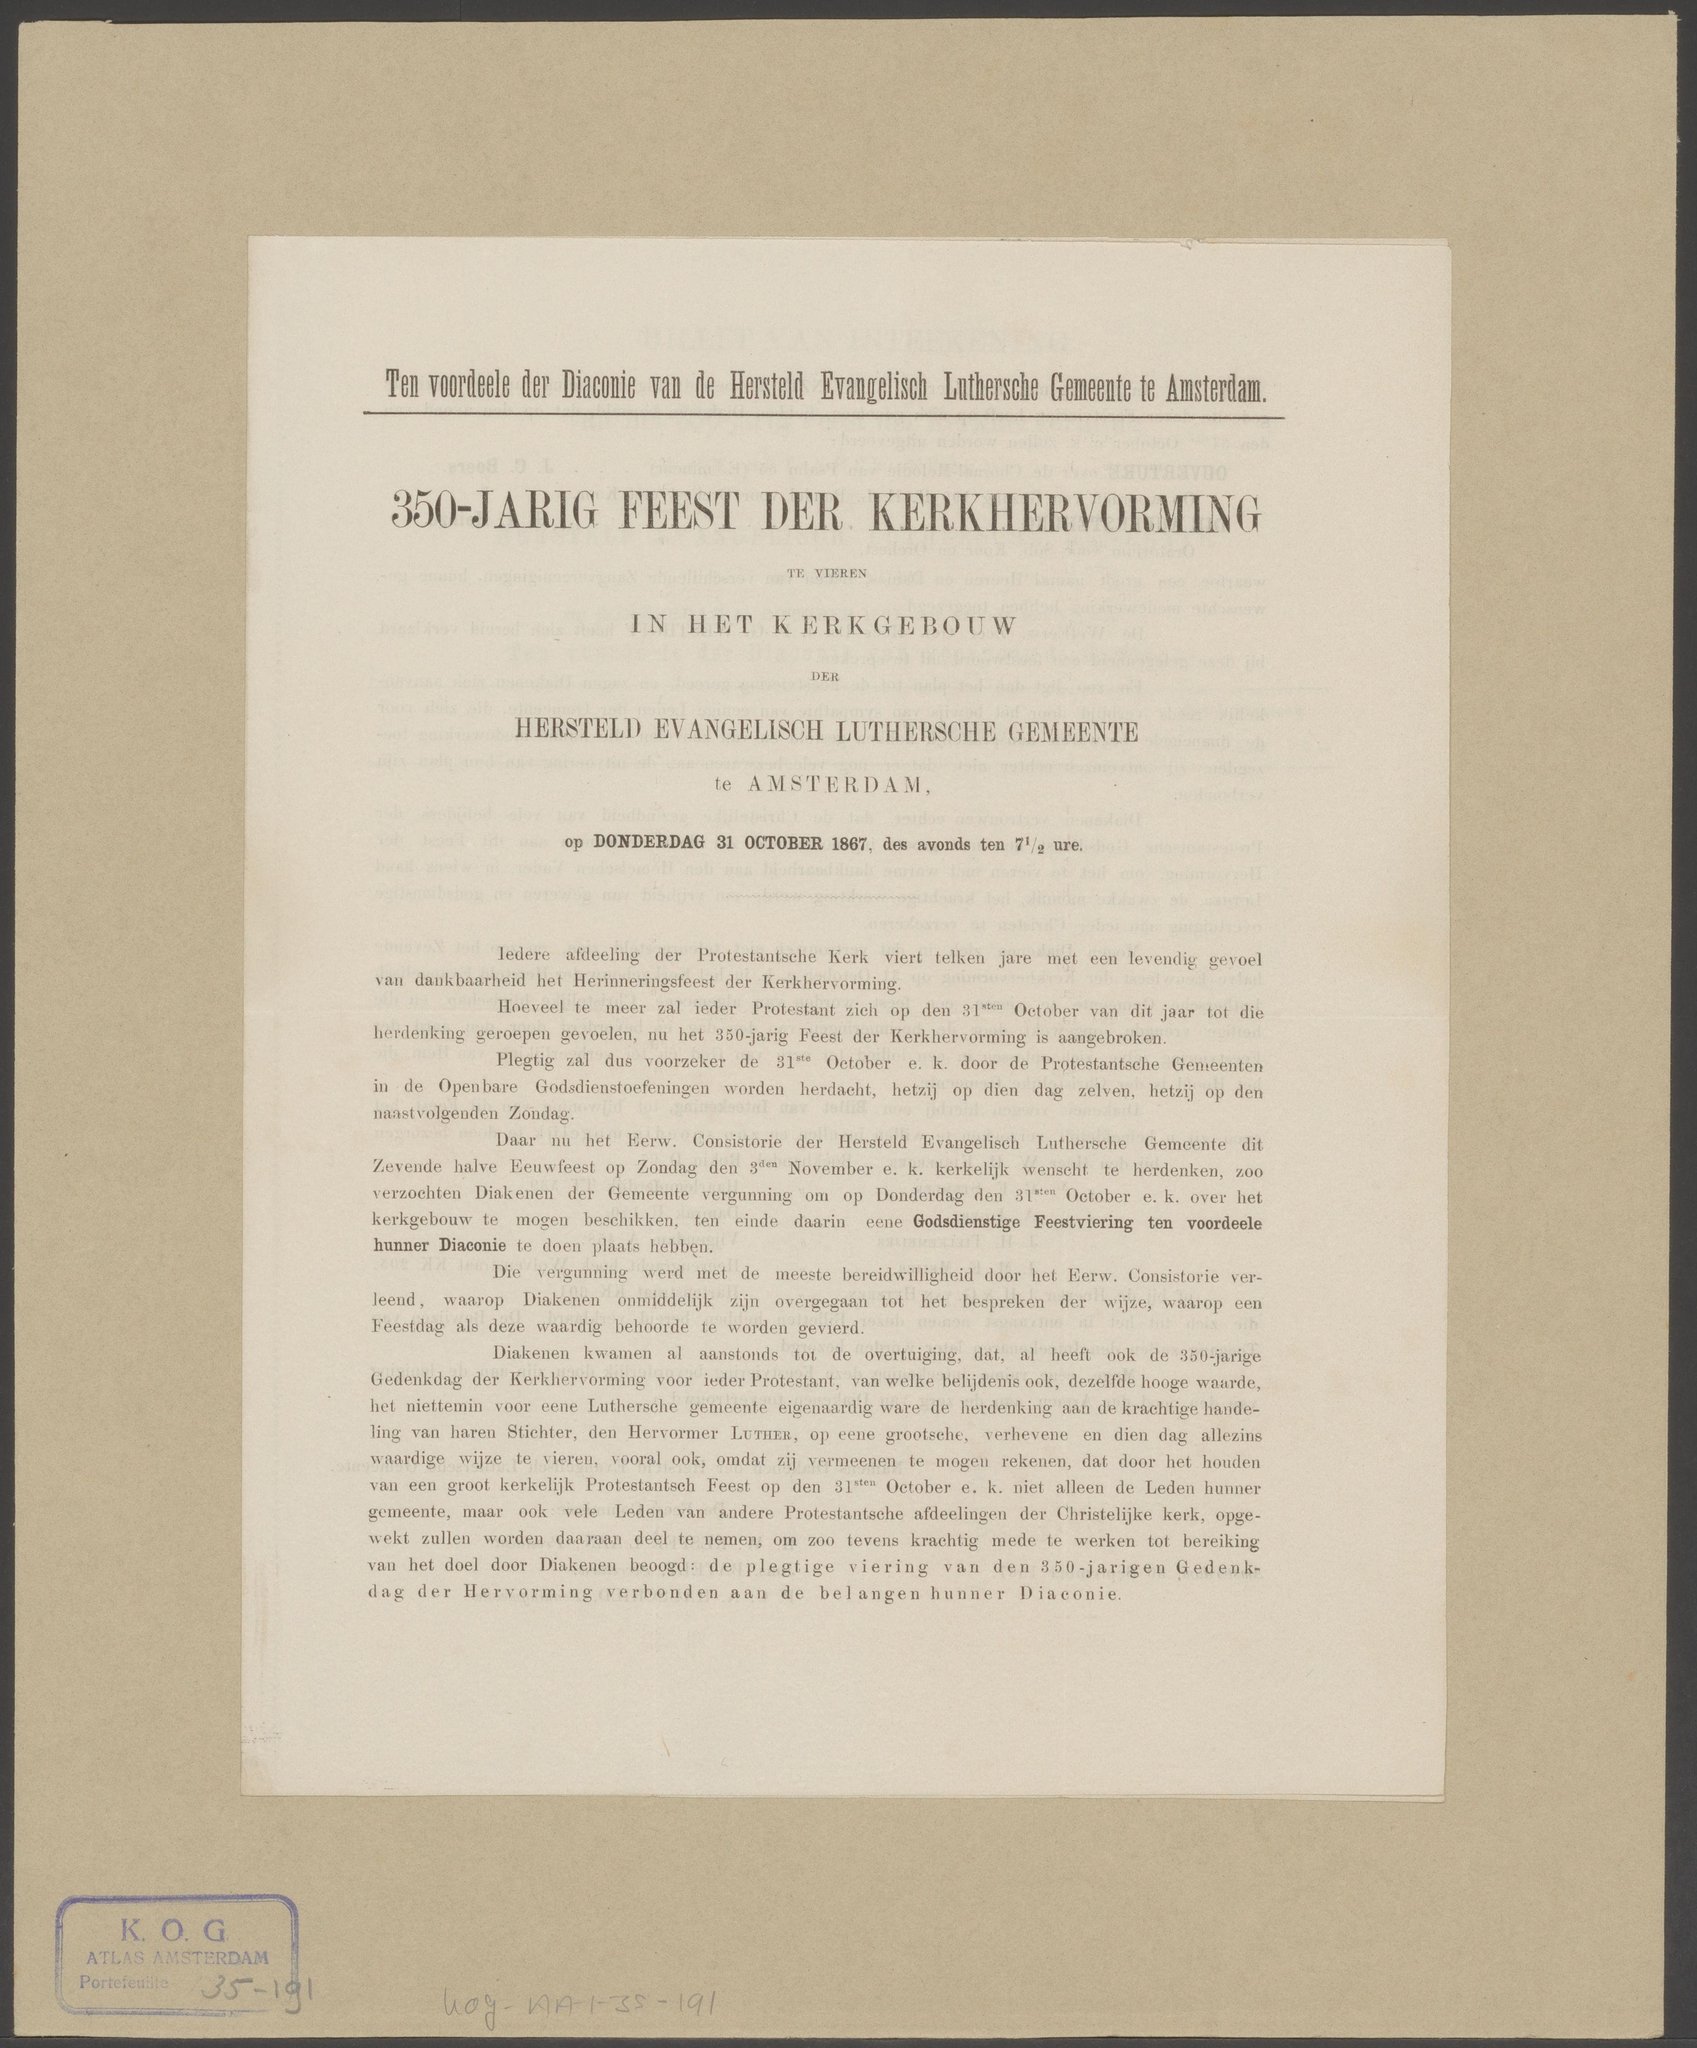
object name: text sheet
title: Aankondiging feest voor het 350-jarig jubilleum van de kerkhervorming van de Hersteld Evangelisch Luthersche gemeente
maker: Anonymous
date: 1867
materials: paper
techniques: letterpress printing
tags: hersteld evangelisch-lutherse kerk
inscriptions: collector's mark: Lugt 1641b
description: Onderwerpsrubriek binnen de Atlas Amsterdam: Kerkwezen: Ev. Lutherse Gemeente: Herst. Ev. Luth. Gemeente.